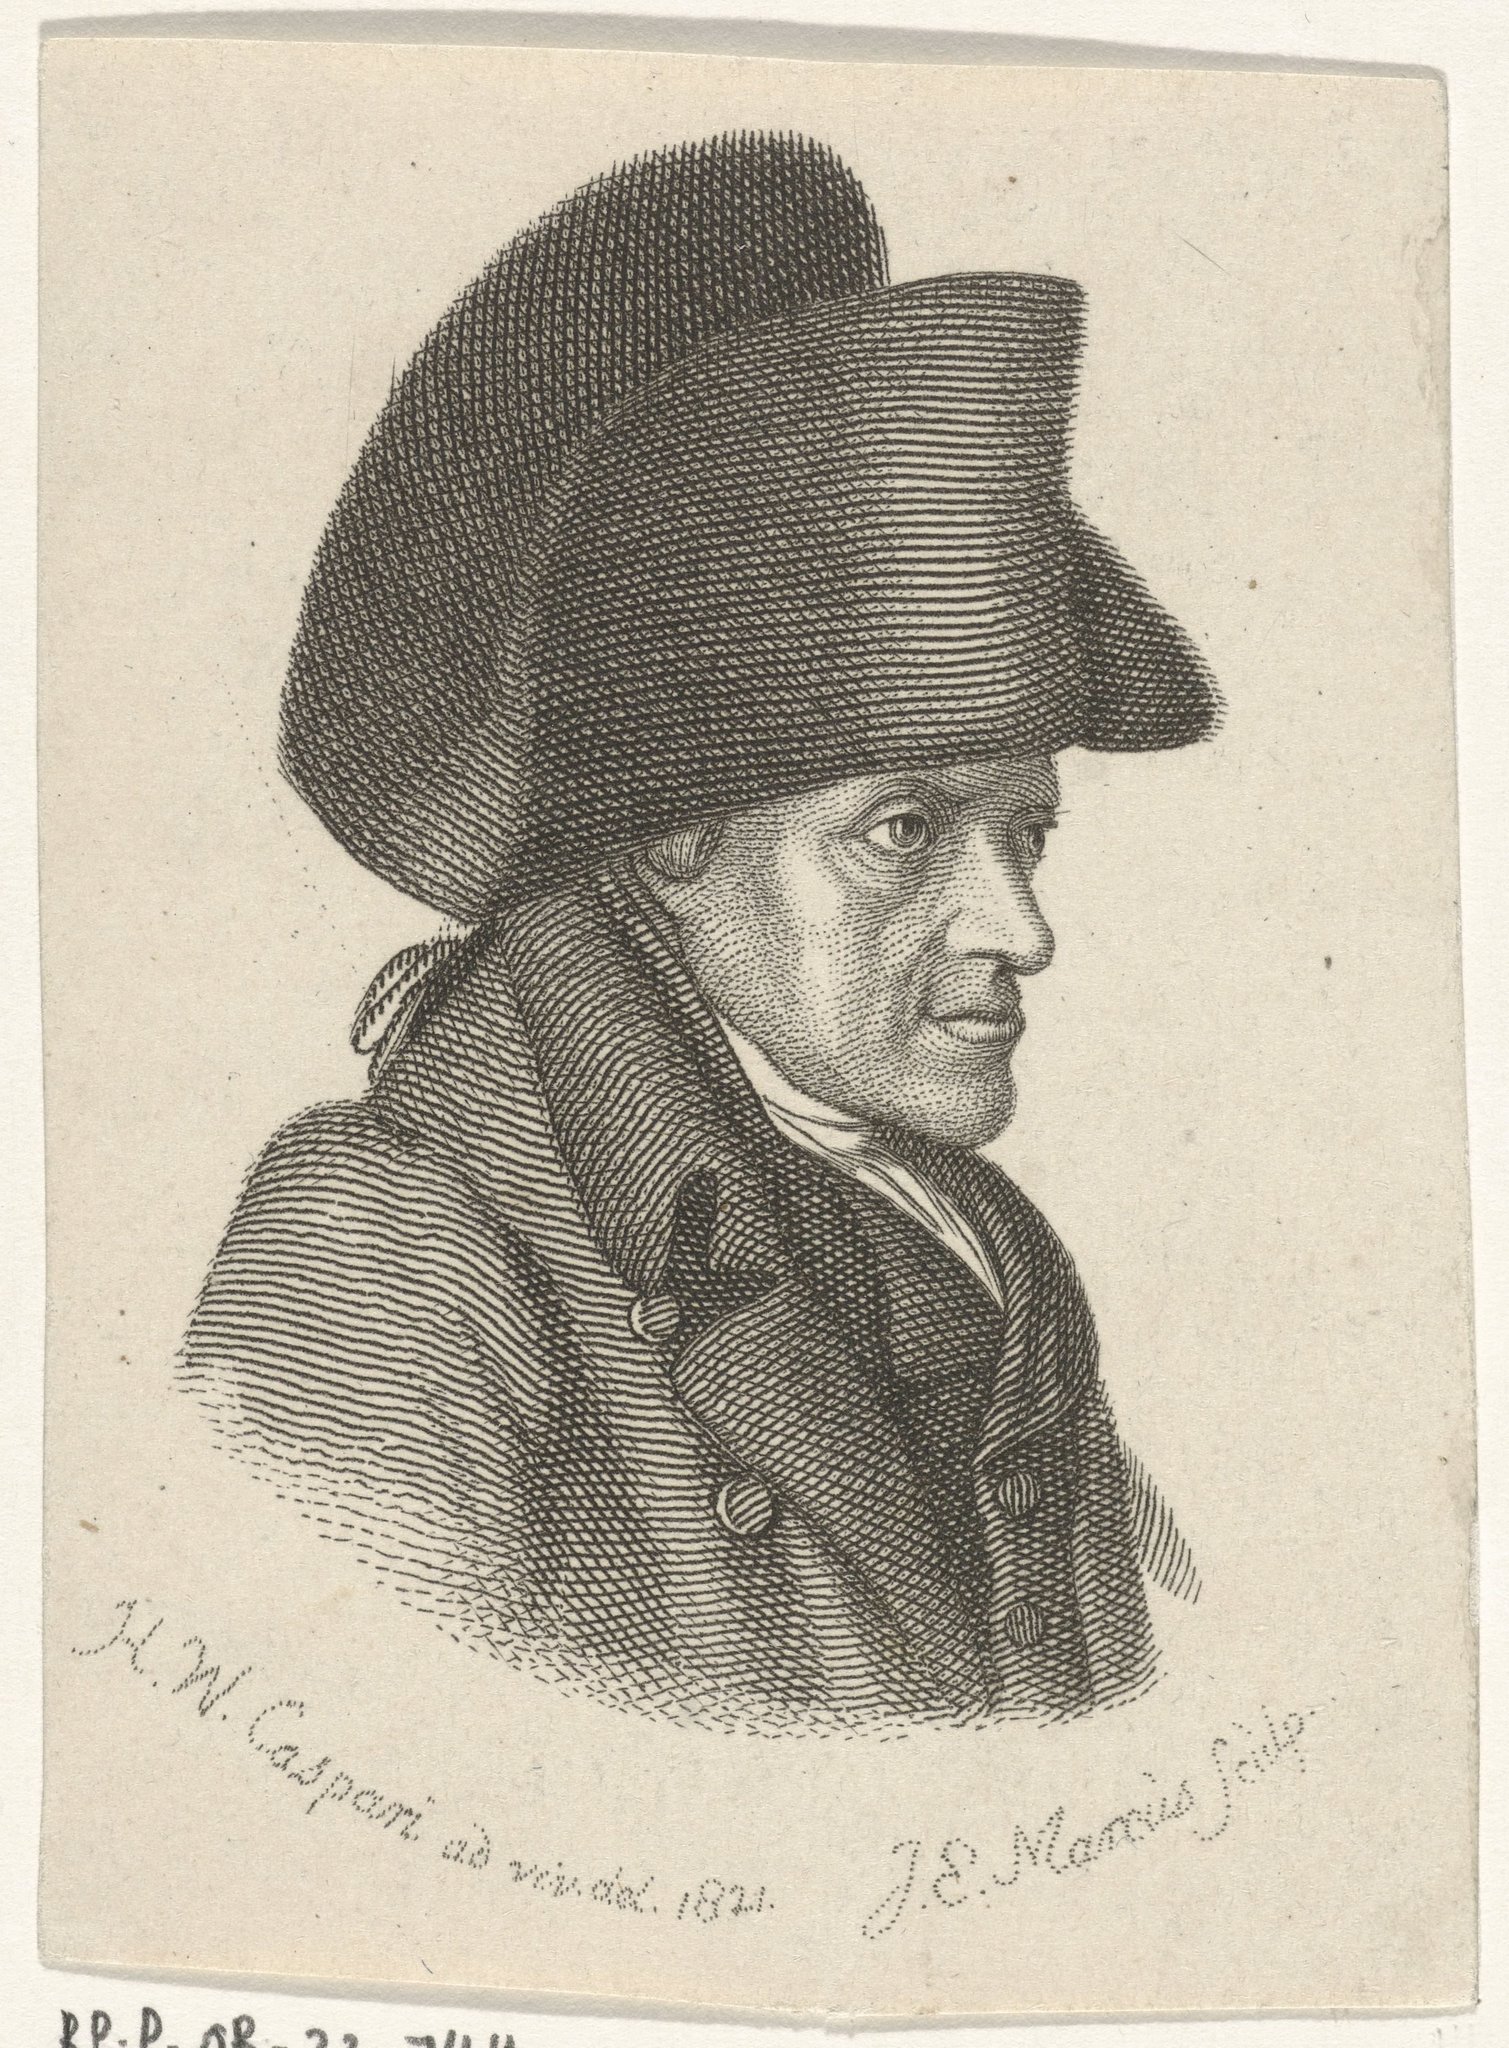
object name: print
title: Portret van Hidde Heeremiet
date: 1821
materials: paper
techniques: etching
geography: amsterdam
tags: wiskundige, boekhouder, hidde heeremiet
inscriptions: collector's mark: Lugt 2228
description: Volgens Van Someren prent gebruikt in: Jan Hendrik Trieper (Jr.), Lofrede op Hidde Heeremiet, in leven secretaris der Maatschappij: Felix Meritis: uitgesproken op den 11den october 1821, te Amsterdam in genoemde Maatschappij. M. Westerman, 1823.